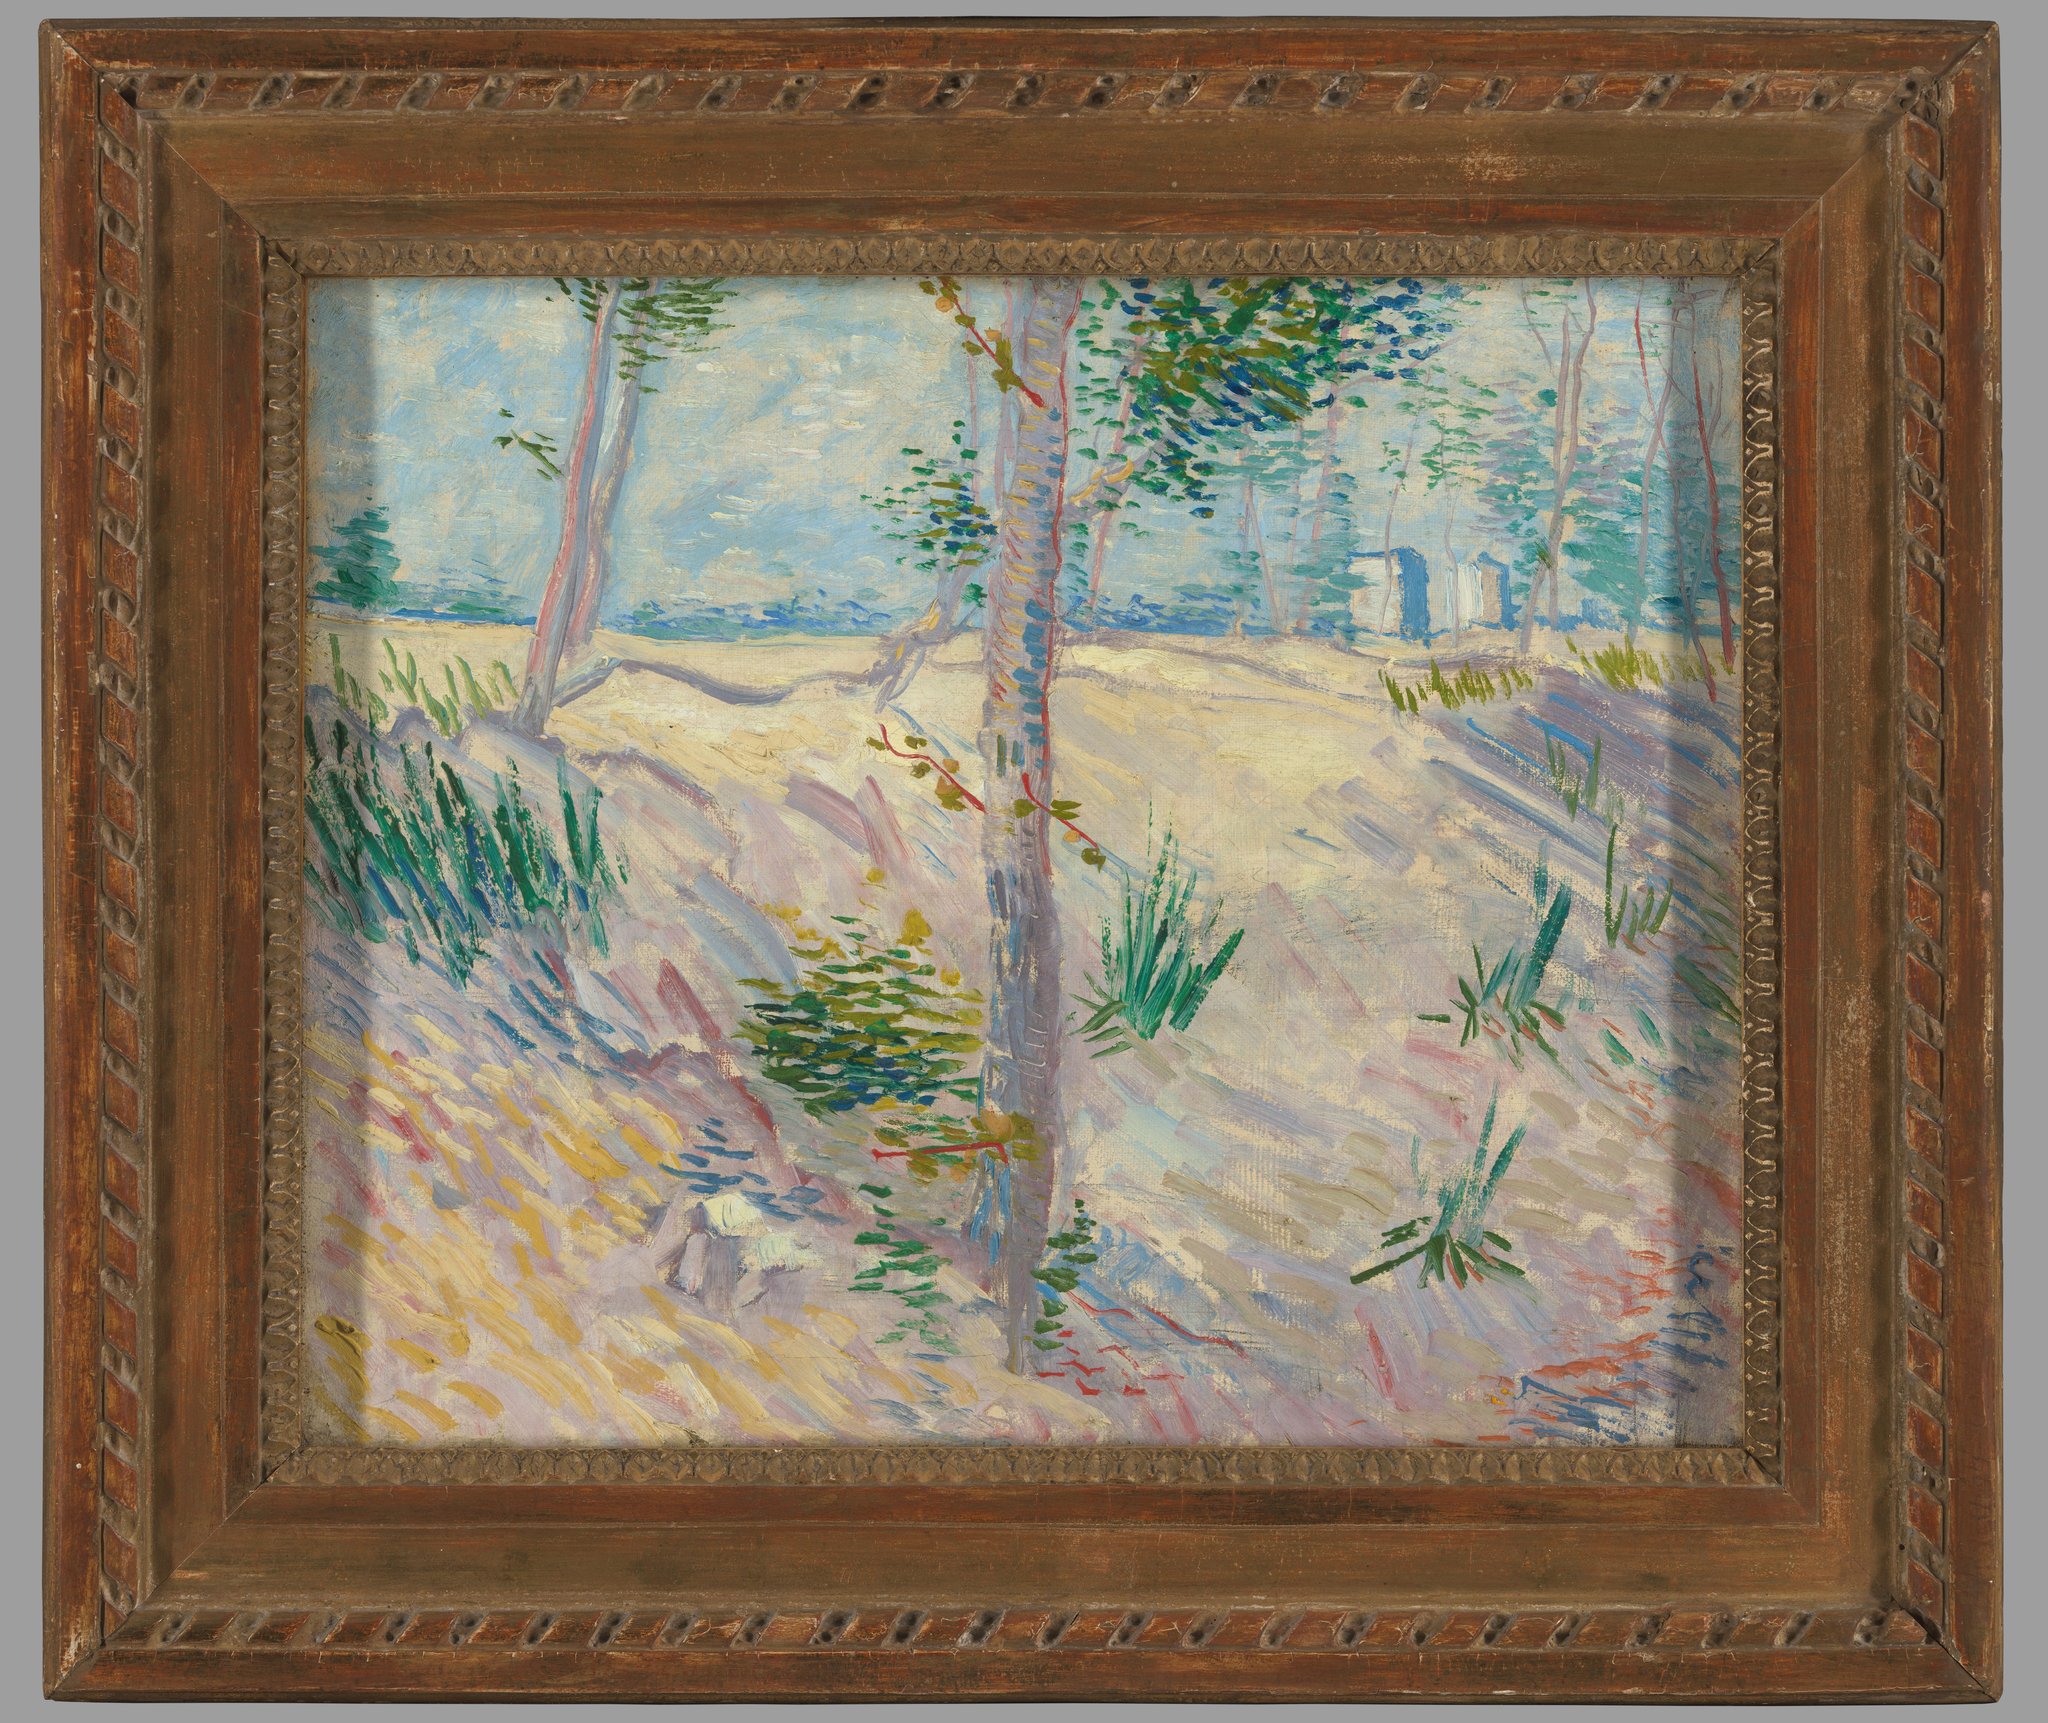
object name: painting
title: Riverbank with Trees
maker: vincent van gogh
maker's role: draughtsman, painter, print maker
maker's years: 1853-1890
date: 1887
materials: canvas, oil, paint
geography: paris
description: In 1886, Van Gogh moved to Paris to familiarise himself in the painting style of the French Impressionists. This painting reflects his experimentation with their bright vibrant colours, short brushstrokes, and modern compositions. The scene is a close-up of a bank of the Seine River near Asnières, a town northeast of Paris. Van Gogh enjoyed painting there during the summer of 1887.